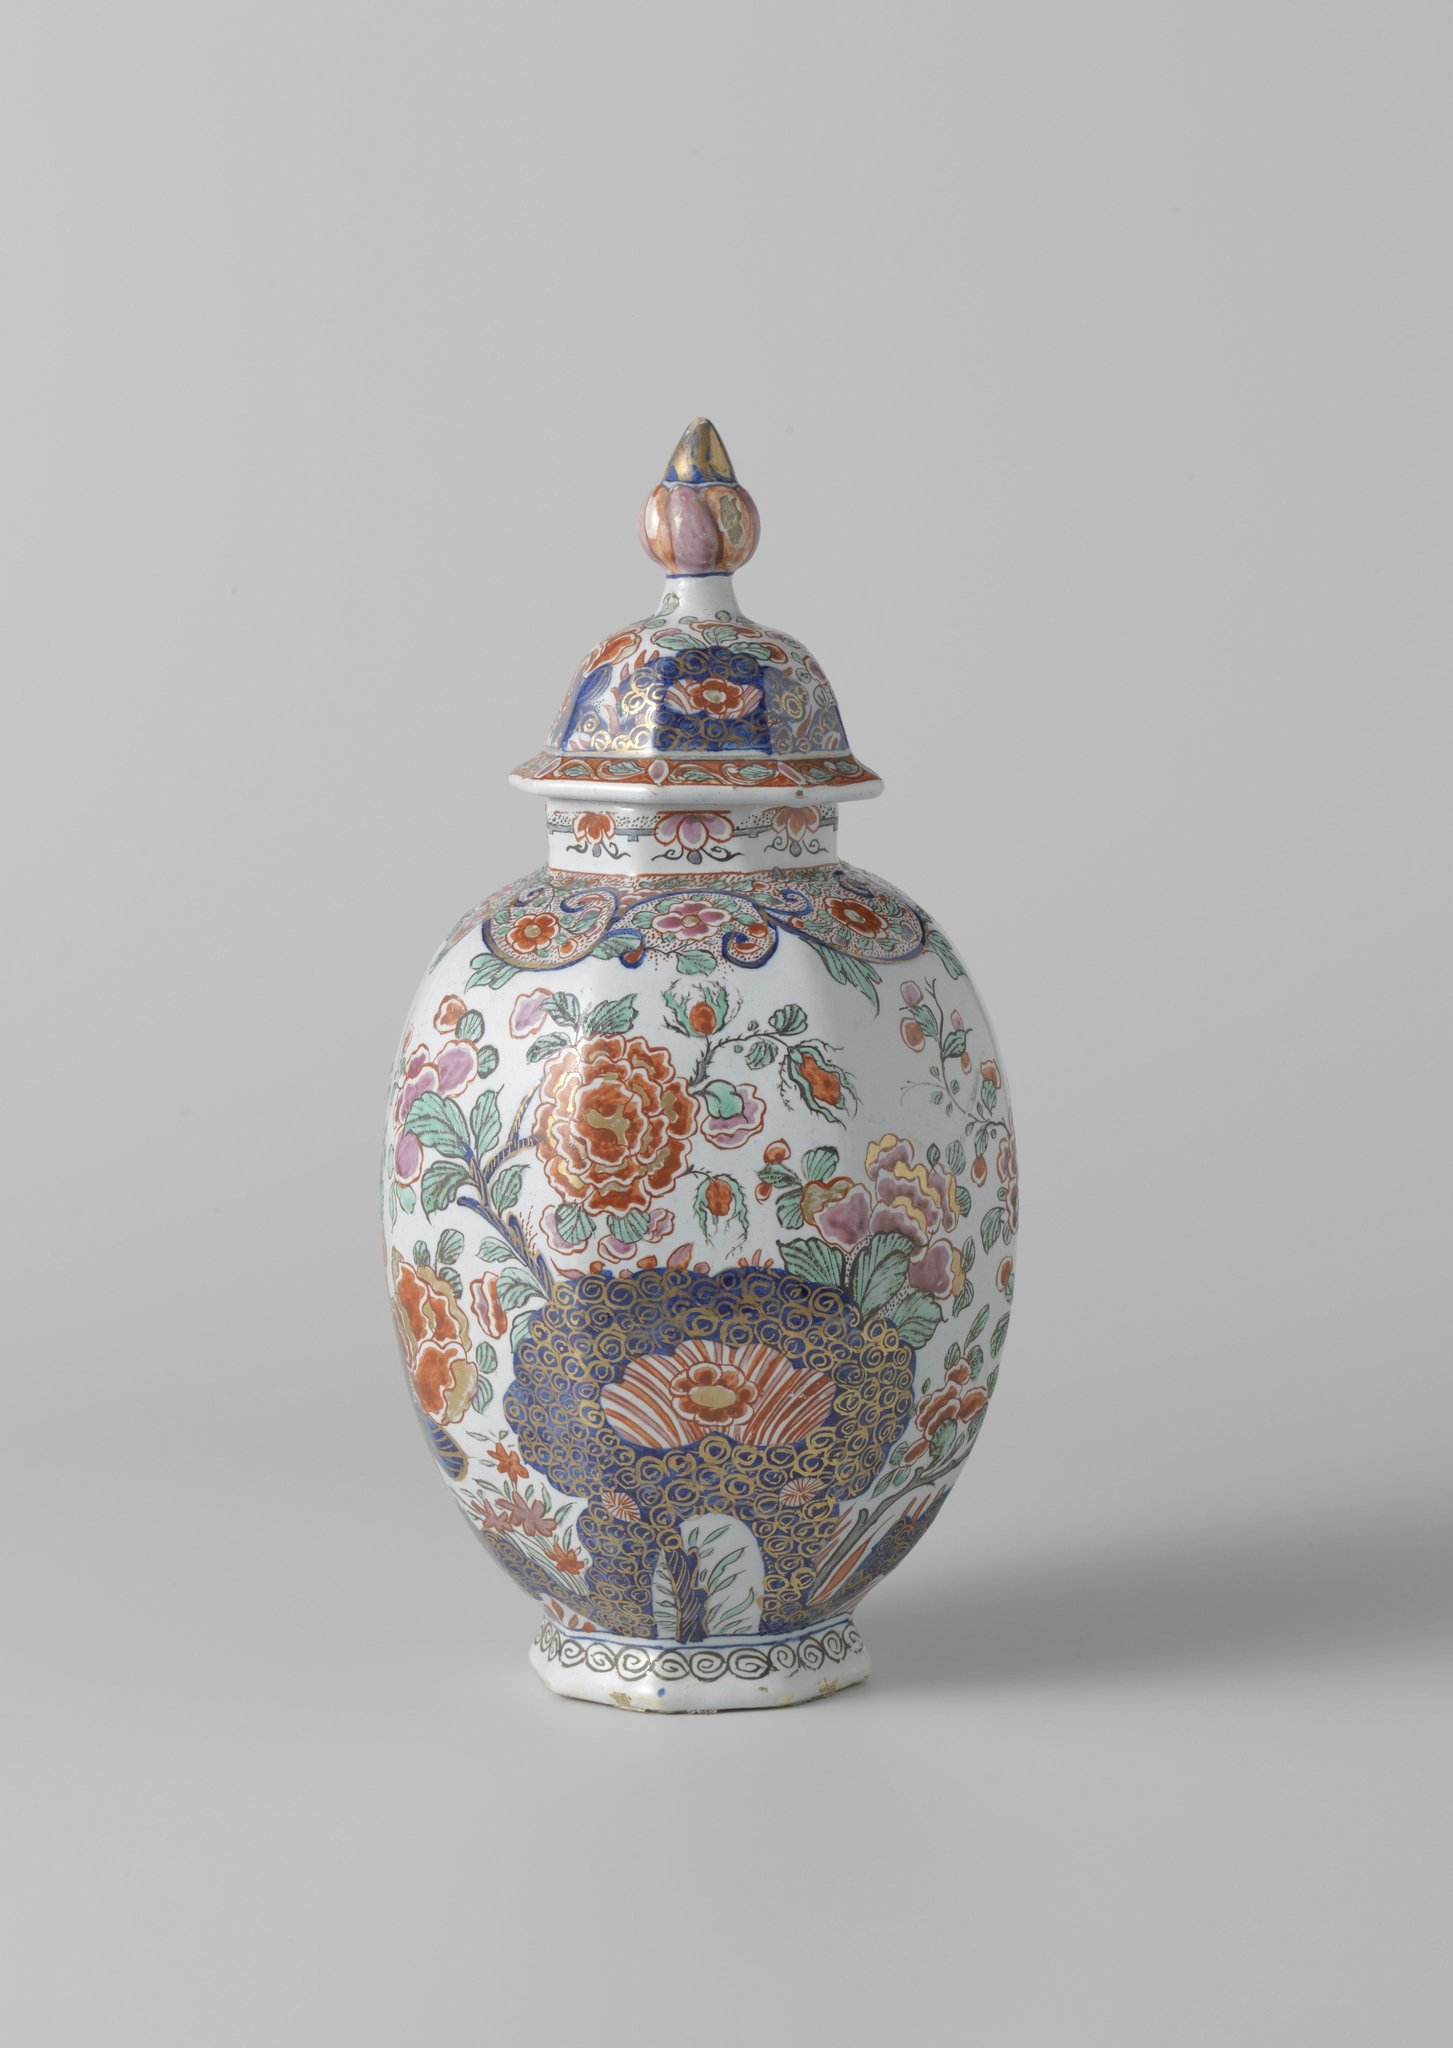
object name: kaststel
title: Pot van veelkleurig beschilderde faïence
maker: Anonymous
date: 1730-1760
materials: faience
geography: delft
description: Pot van faïence. Veelkleurig beschilderd met bloemdecoraties. De pot is een onderdeel van een kaststel.